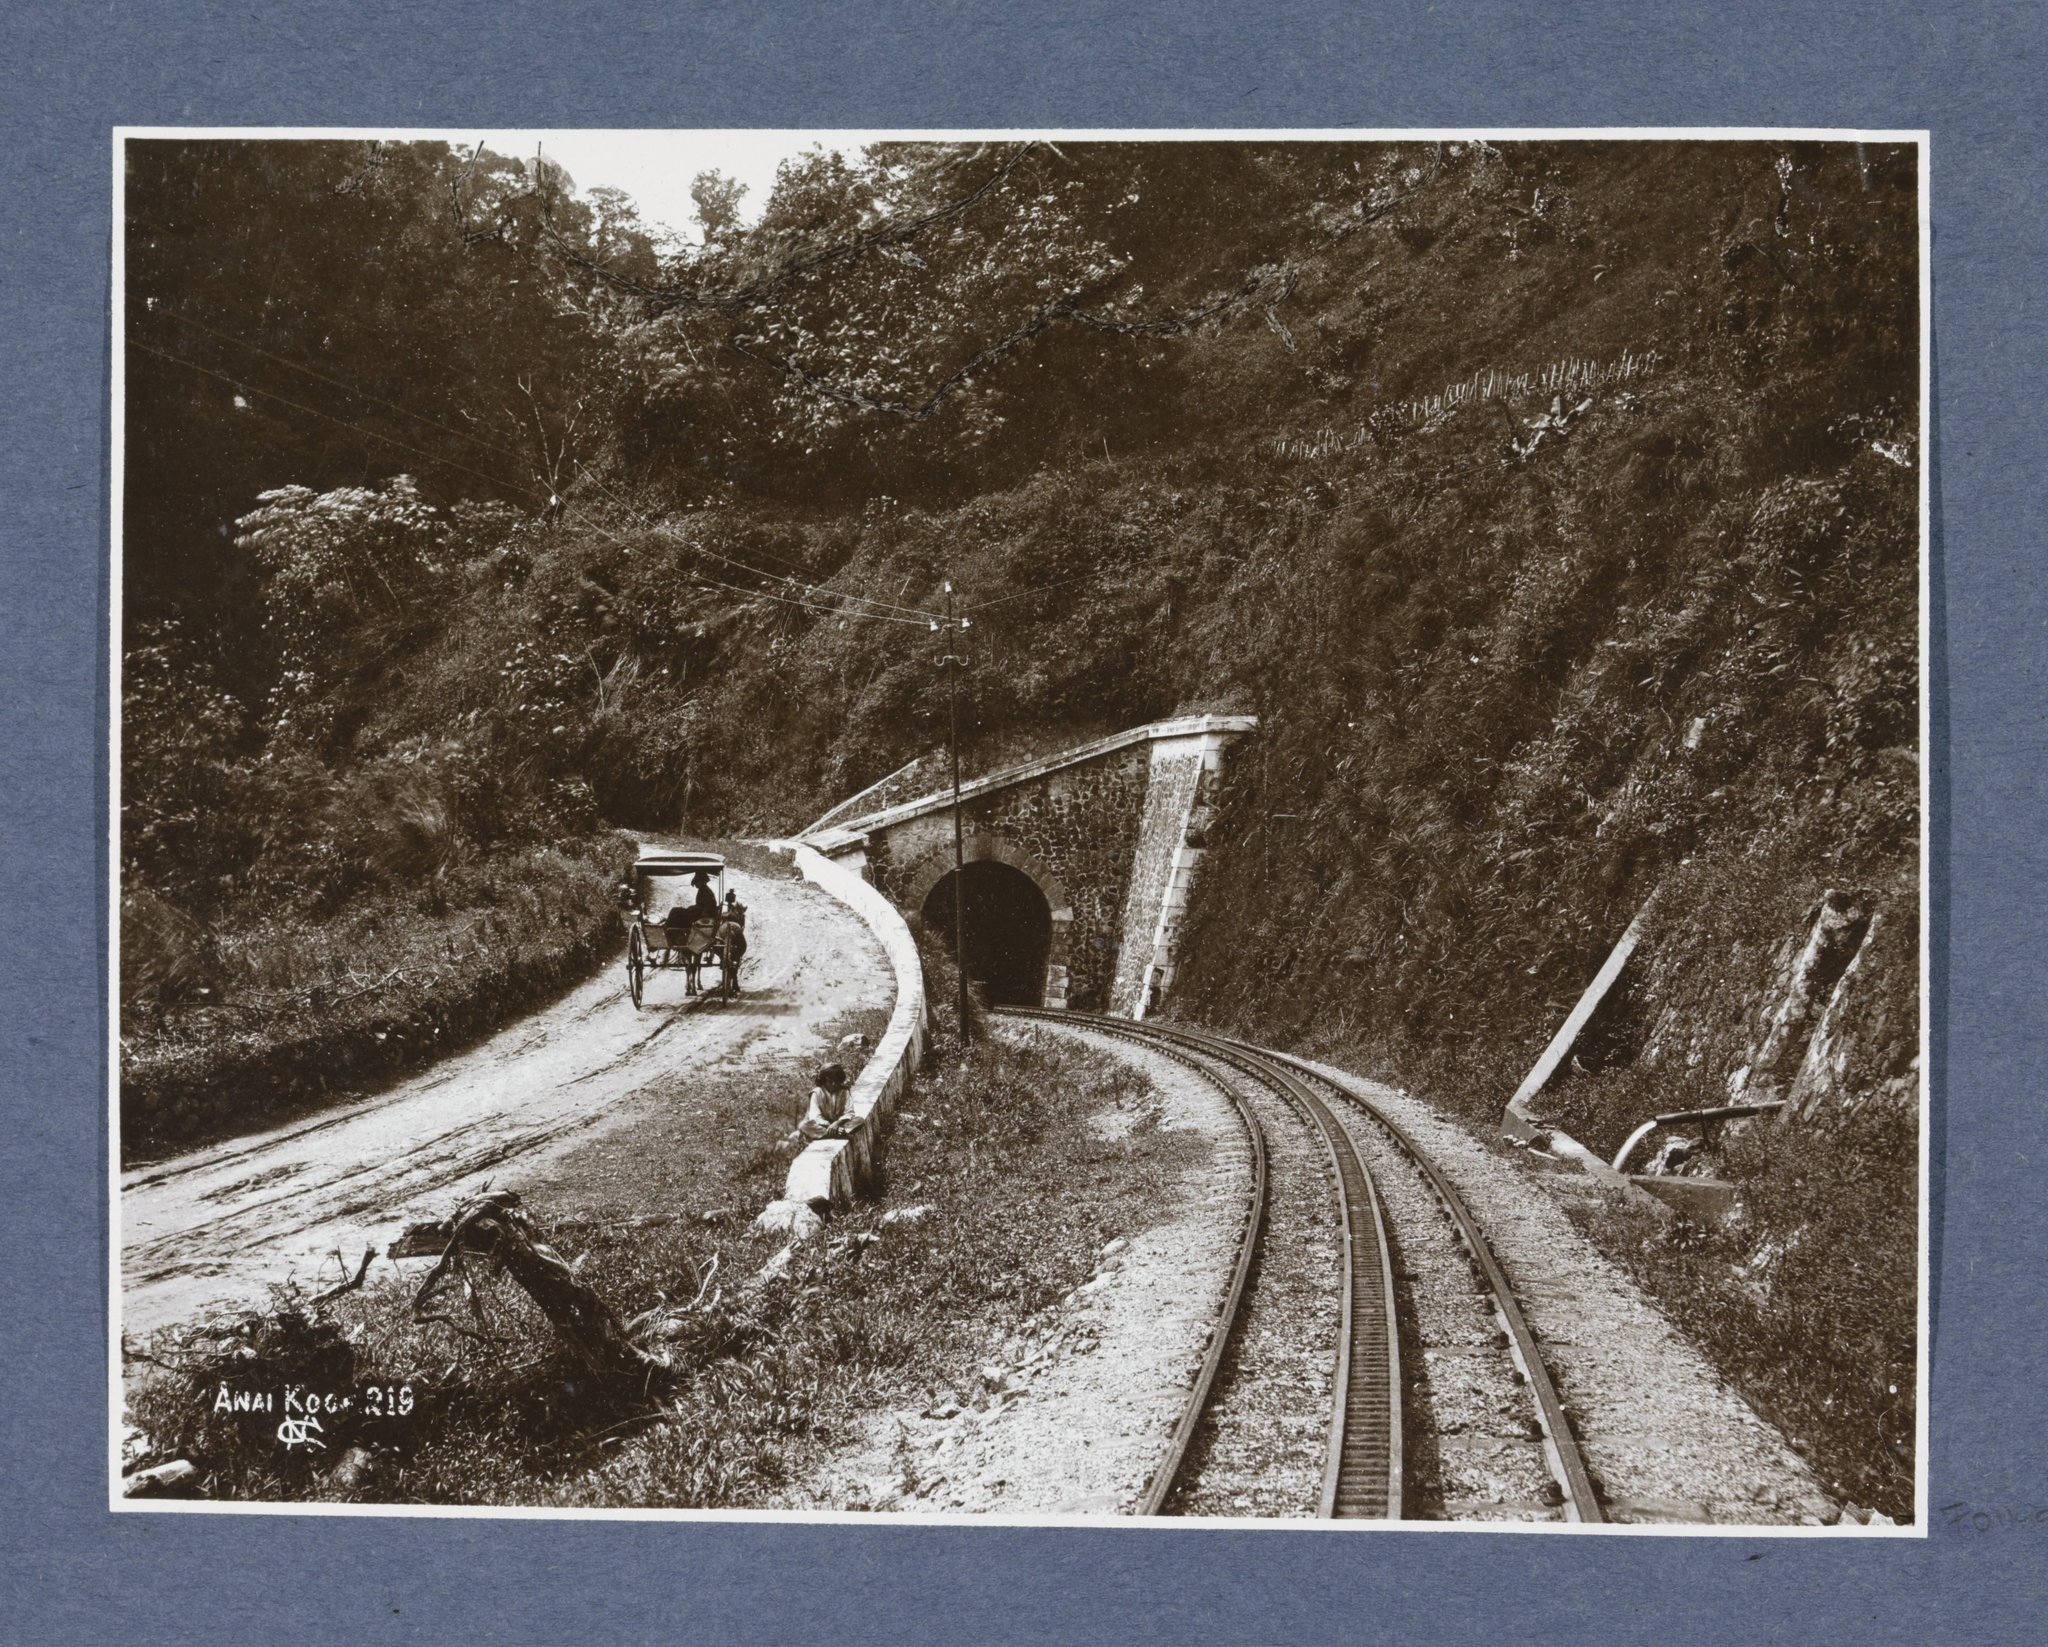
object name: album leaf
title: Spoorwegtunnel en rijtuig in de Anaikloof op Sumatra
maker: christiaan benjamin nieuwenhuis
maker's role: publisher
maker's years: 1863-1922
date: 1900-1920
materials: paper, photographic support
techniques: gelatin silver print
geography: sumatra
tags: two-wheeled, animal-drawn vehicle, ravine, chasm, abyss, canyon, railway, train, underground road, tunnel, sumatra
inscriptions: number: ‘219’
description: Onderdeel van reisalbum met foto's van bedrijvigheid en bezienswaardigheden op Sumatra en Java en van de reis naar en van Nederlands-Indië.